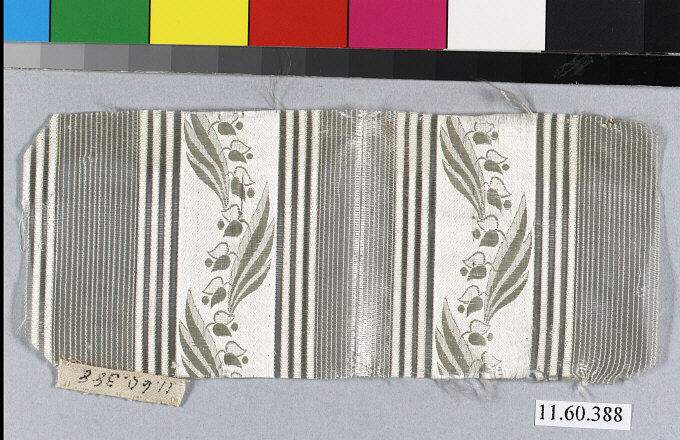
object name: fragment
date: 1801-1900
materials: silk